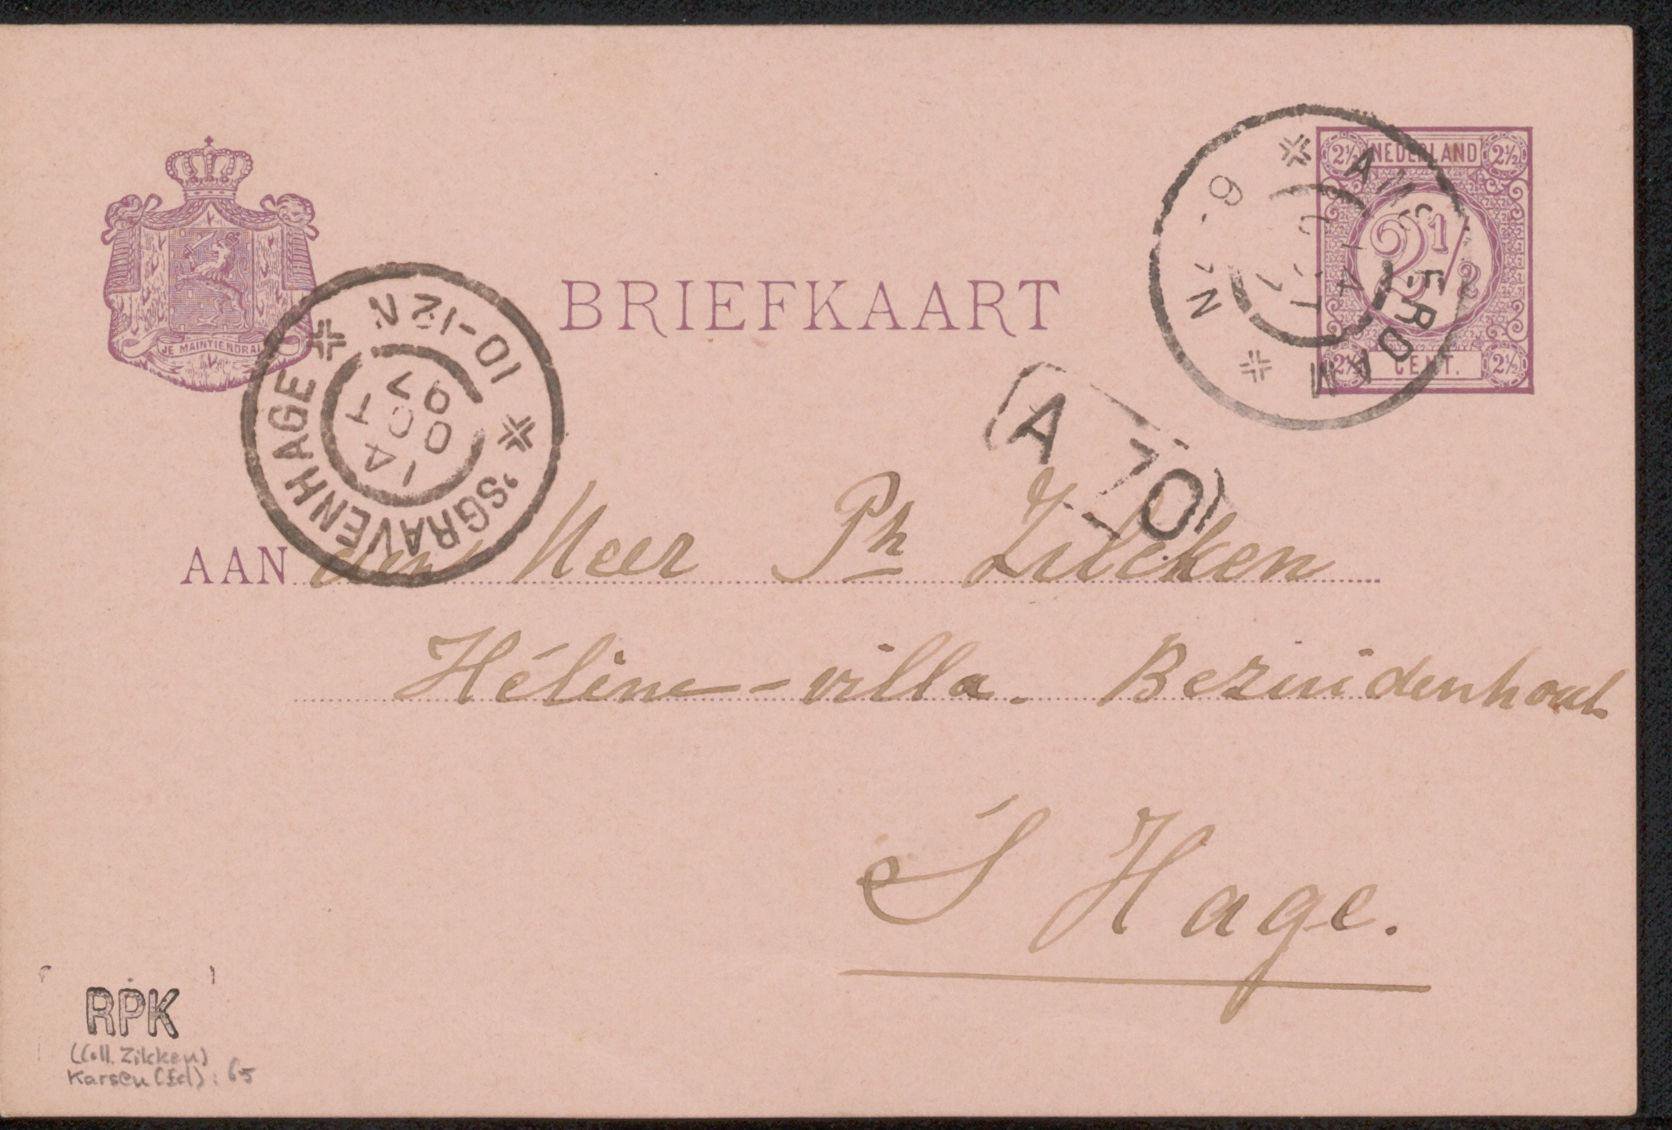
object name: postcard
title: Briefkaart aan Philip Zilcken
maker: eduard karsen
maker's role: draughtsman, painter, print maker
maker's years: 1860-1941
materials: cardboard, ink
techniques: pen, writing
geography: amsterdam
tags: the hague, painter, draughtsman, philip zilcken, sending and receiving postal matter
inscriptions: collector's mark: ‘RPK’